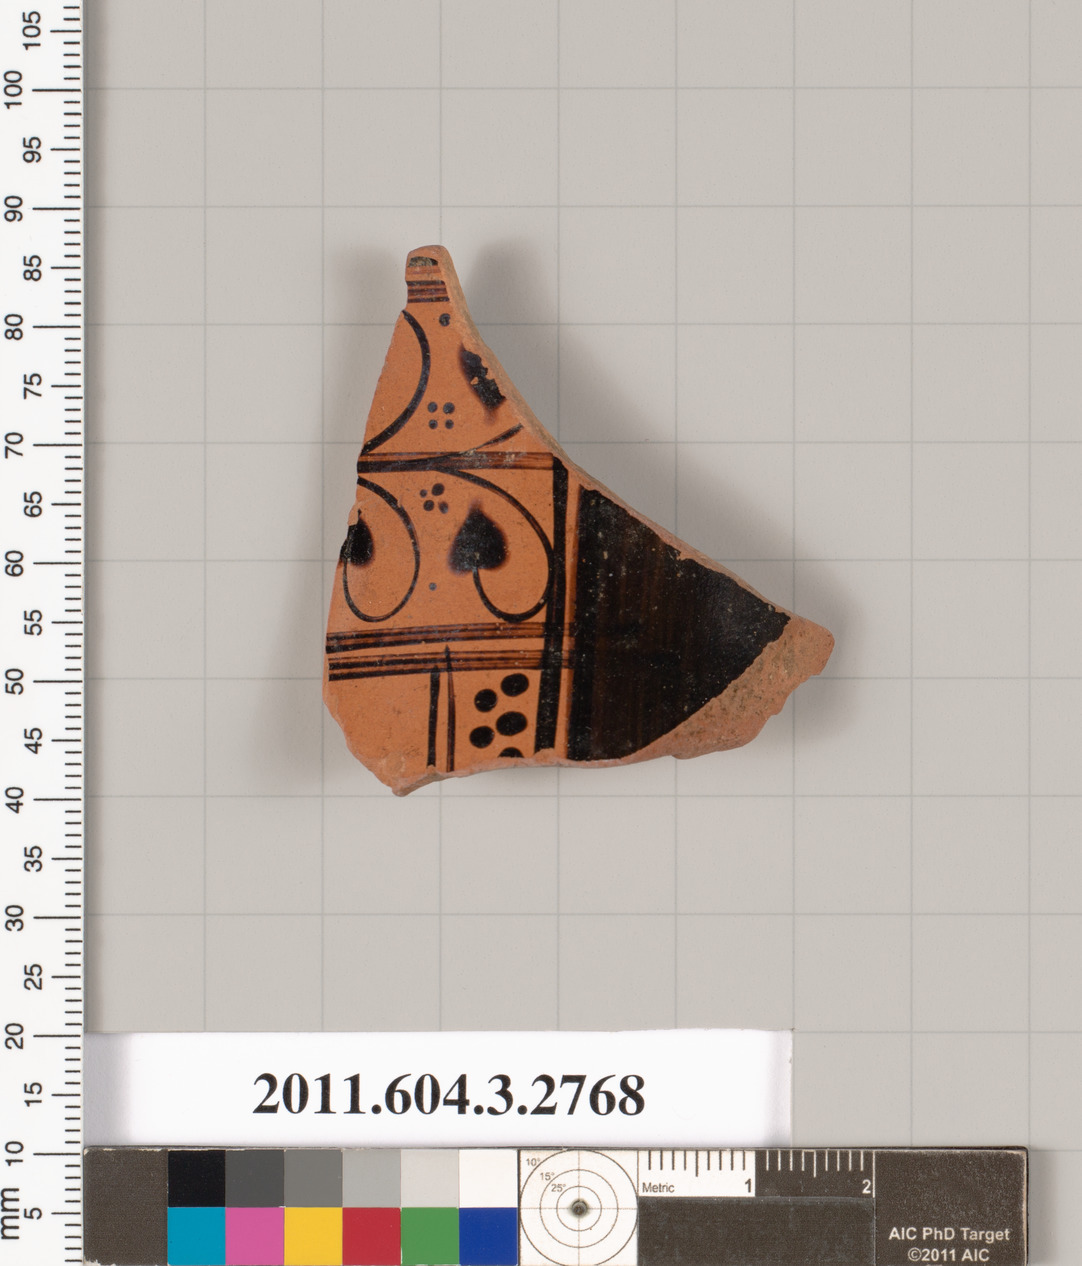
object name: olpe fragment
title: Terracotta fragment of an olpe (jug)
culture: greek, attic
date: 525-501 BCE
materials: terracotta